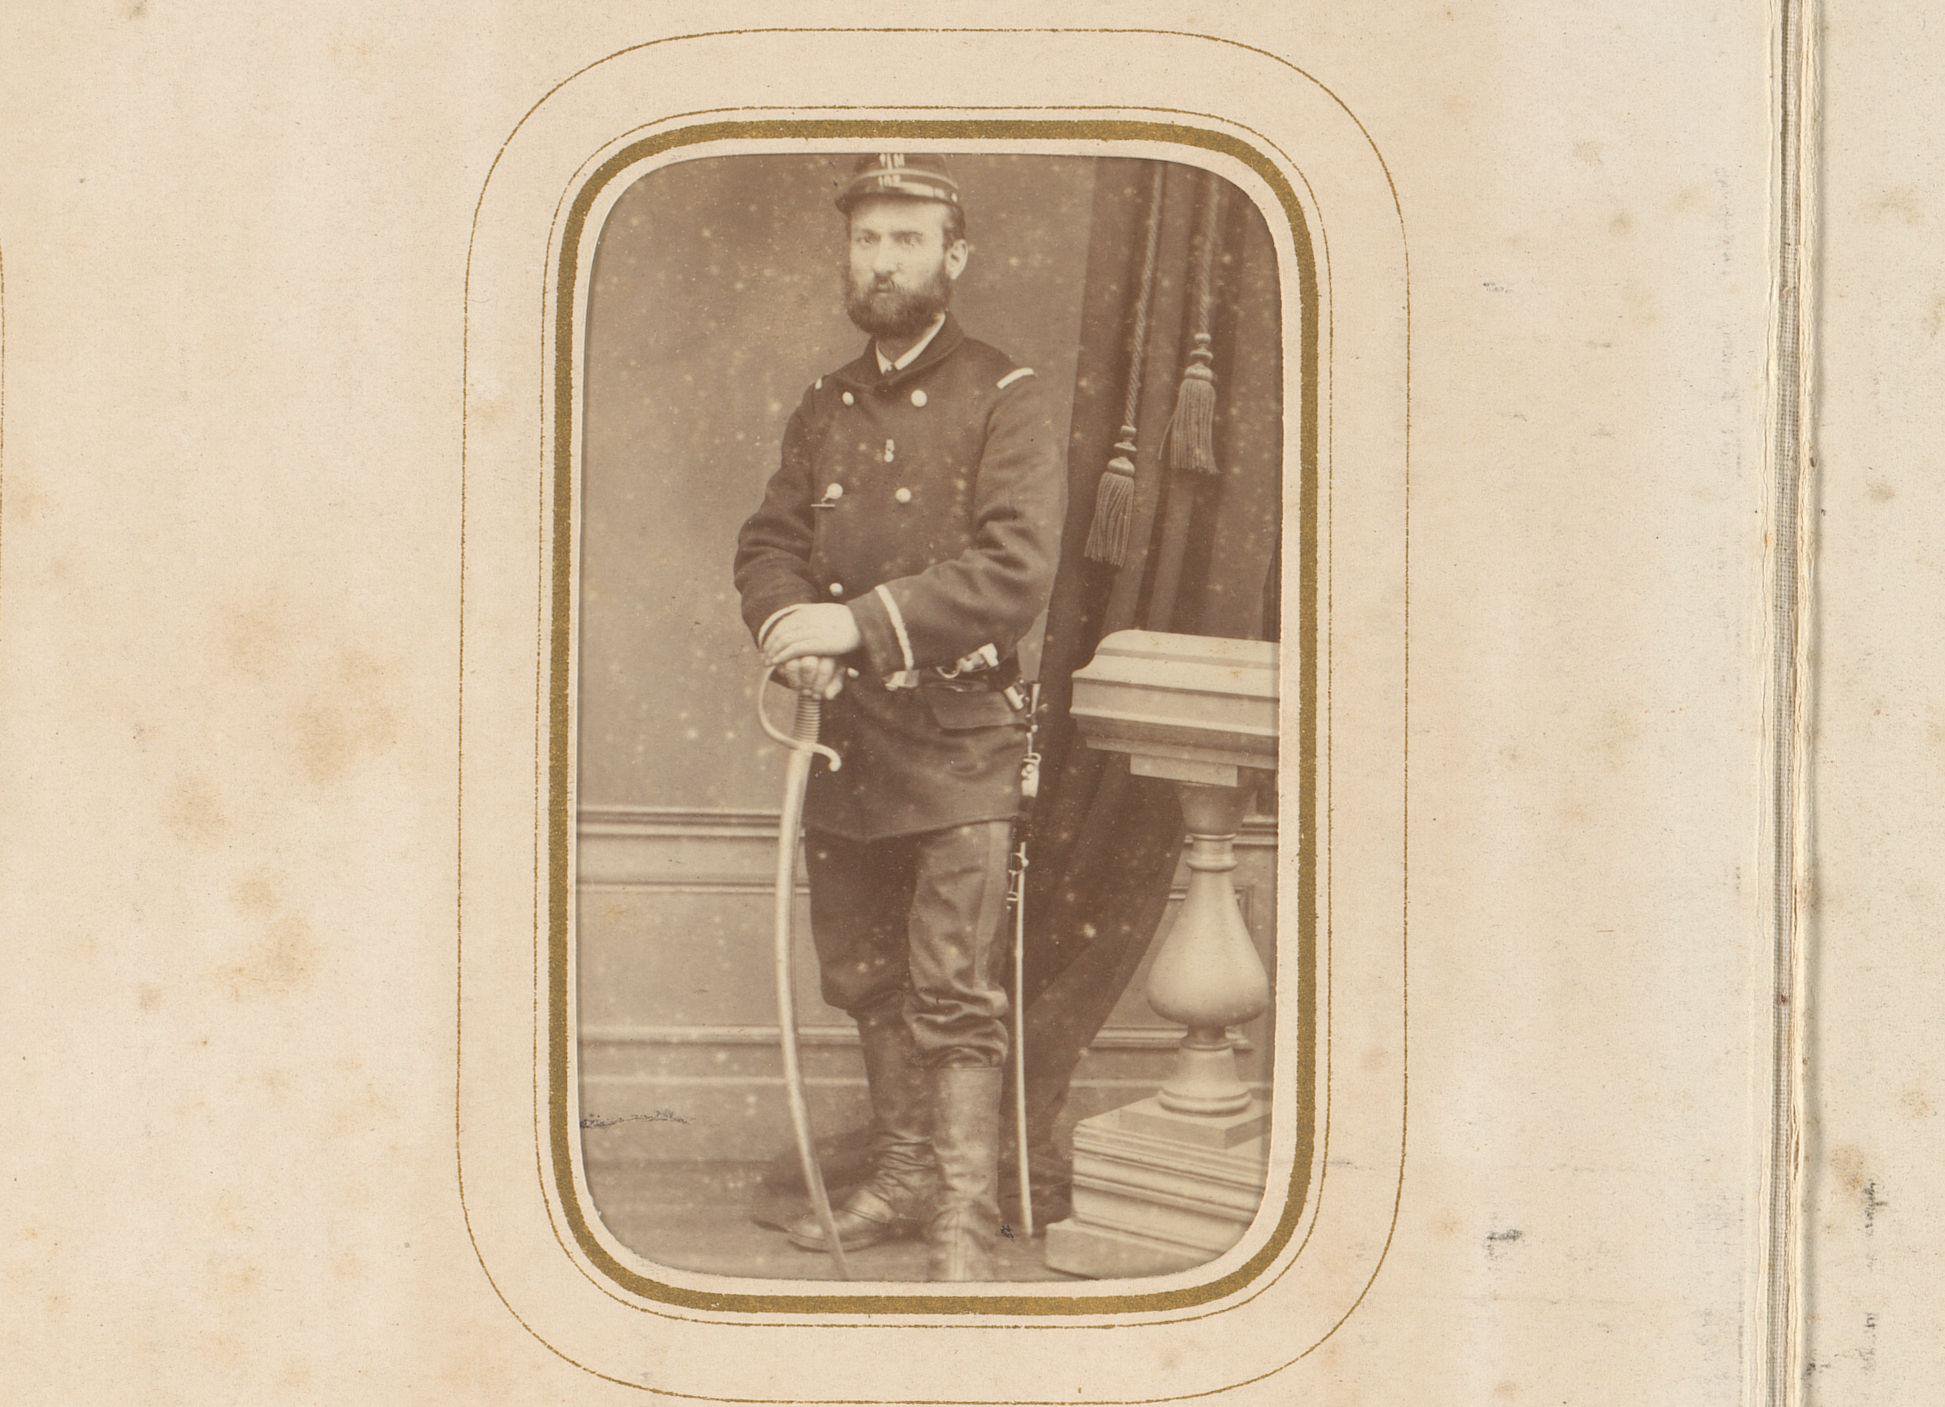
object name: carte de visite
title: Portret van een man in uniform met sabel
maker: Anonymous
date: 1860-1890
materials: cardboard, photographic support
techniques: albumen print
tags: historical persons, hacking and thrusting weapons: sword, (military) uniforms